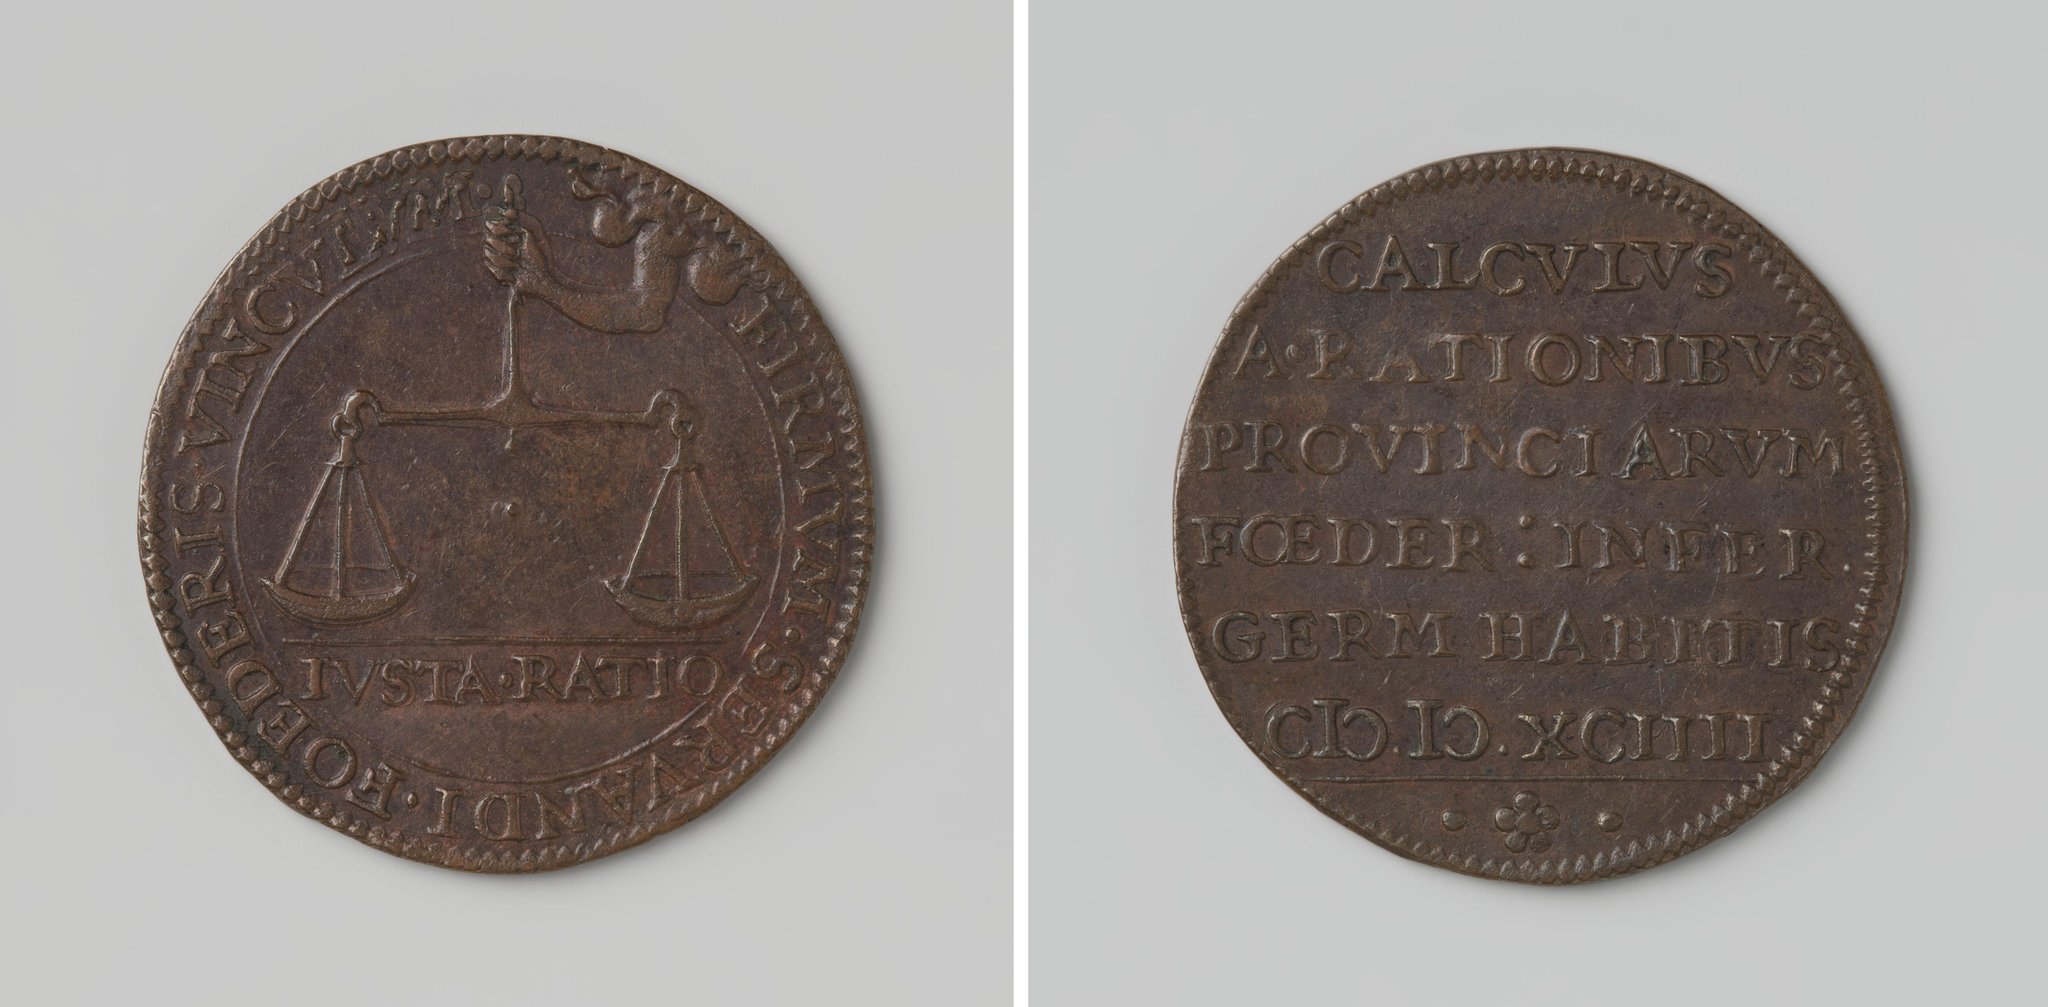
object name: jeton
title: Opmaken van de rekening der onafhankelijke Nederlandse gewesten, rekenpenning van de Raad van State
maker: Anonymous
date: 1594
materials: copper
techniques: striking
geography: dordrecht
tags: raad van state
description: Koperen penning. Voorzijde: hand uit wolken houdt in evenwicht zijnde weegschaal vast binnen omschrift; afsnede: opschrift. Keerzijde: opschrift